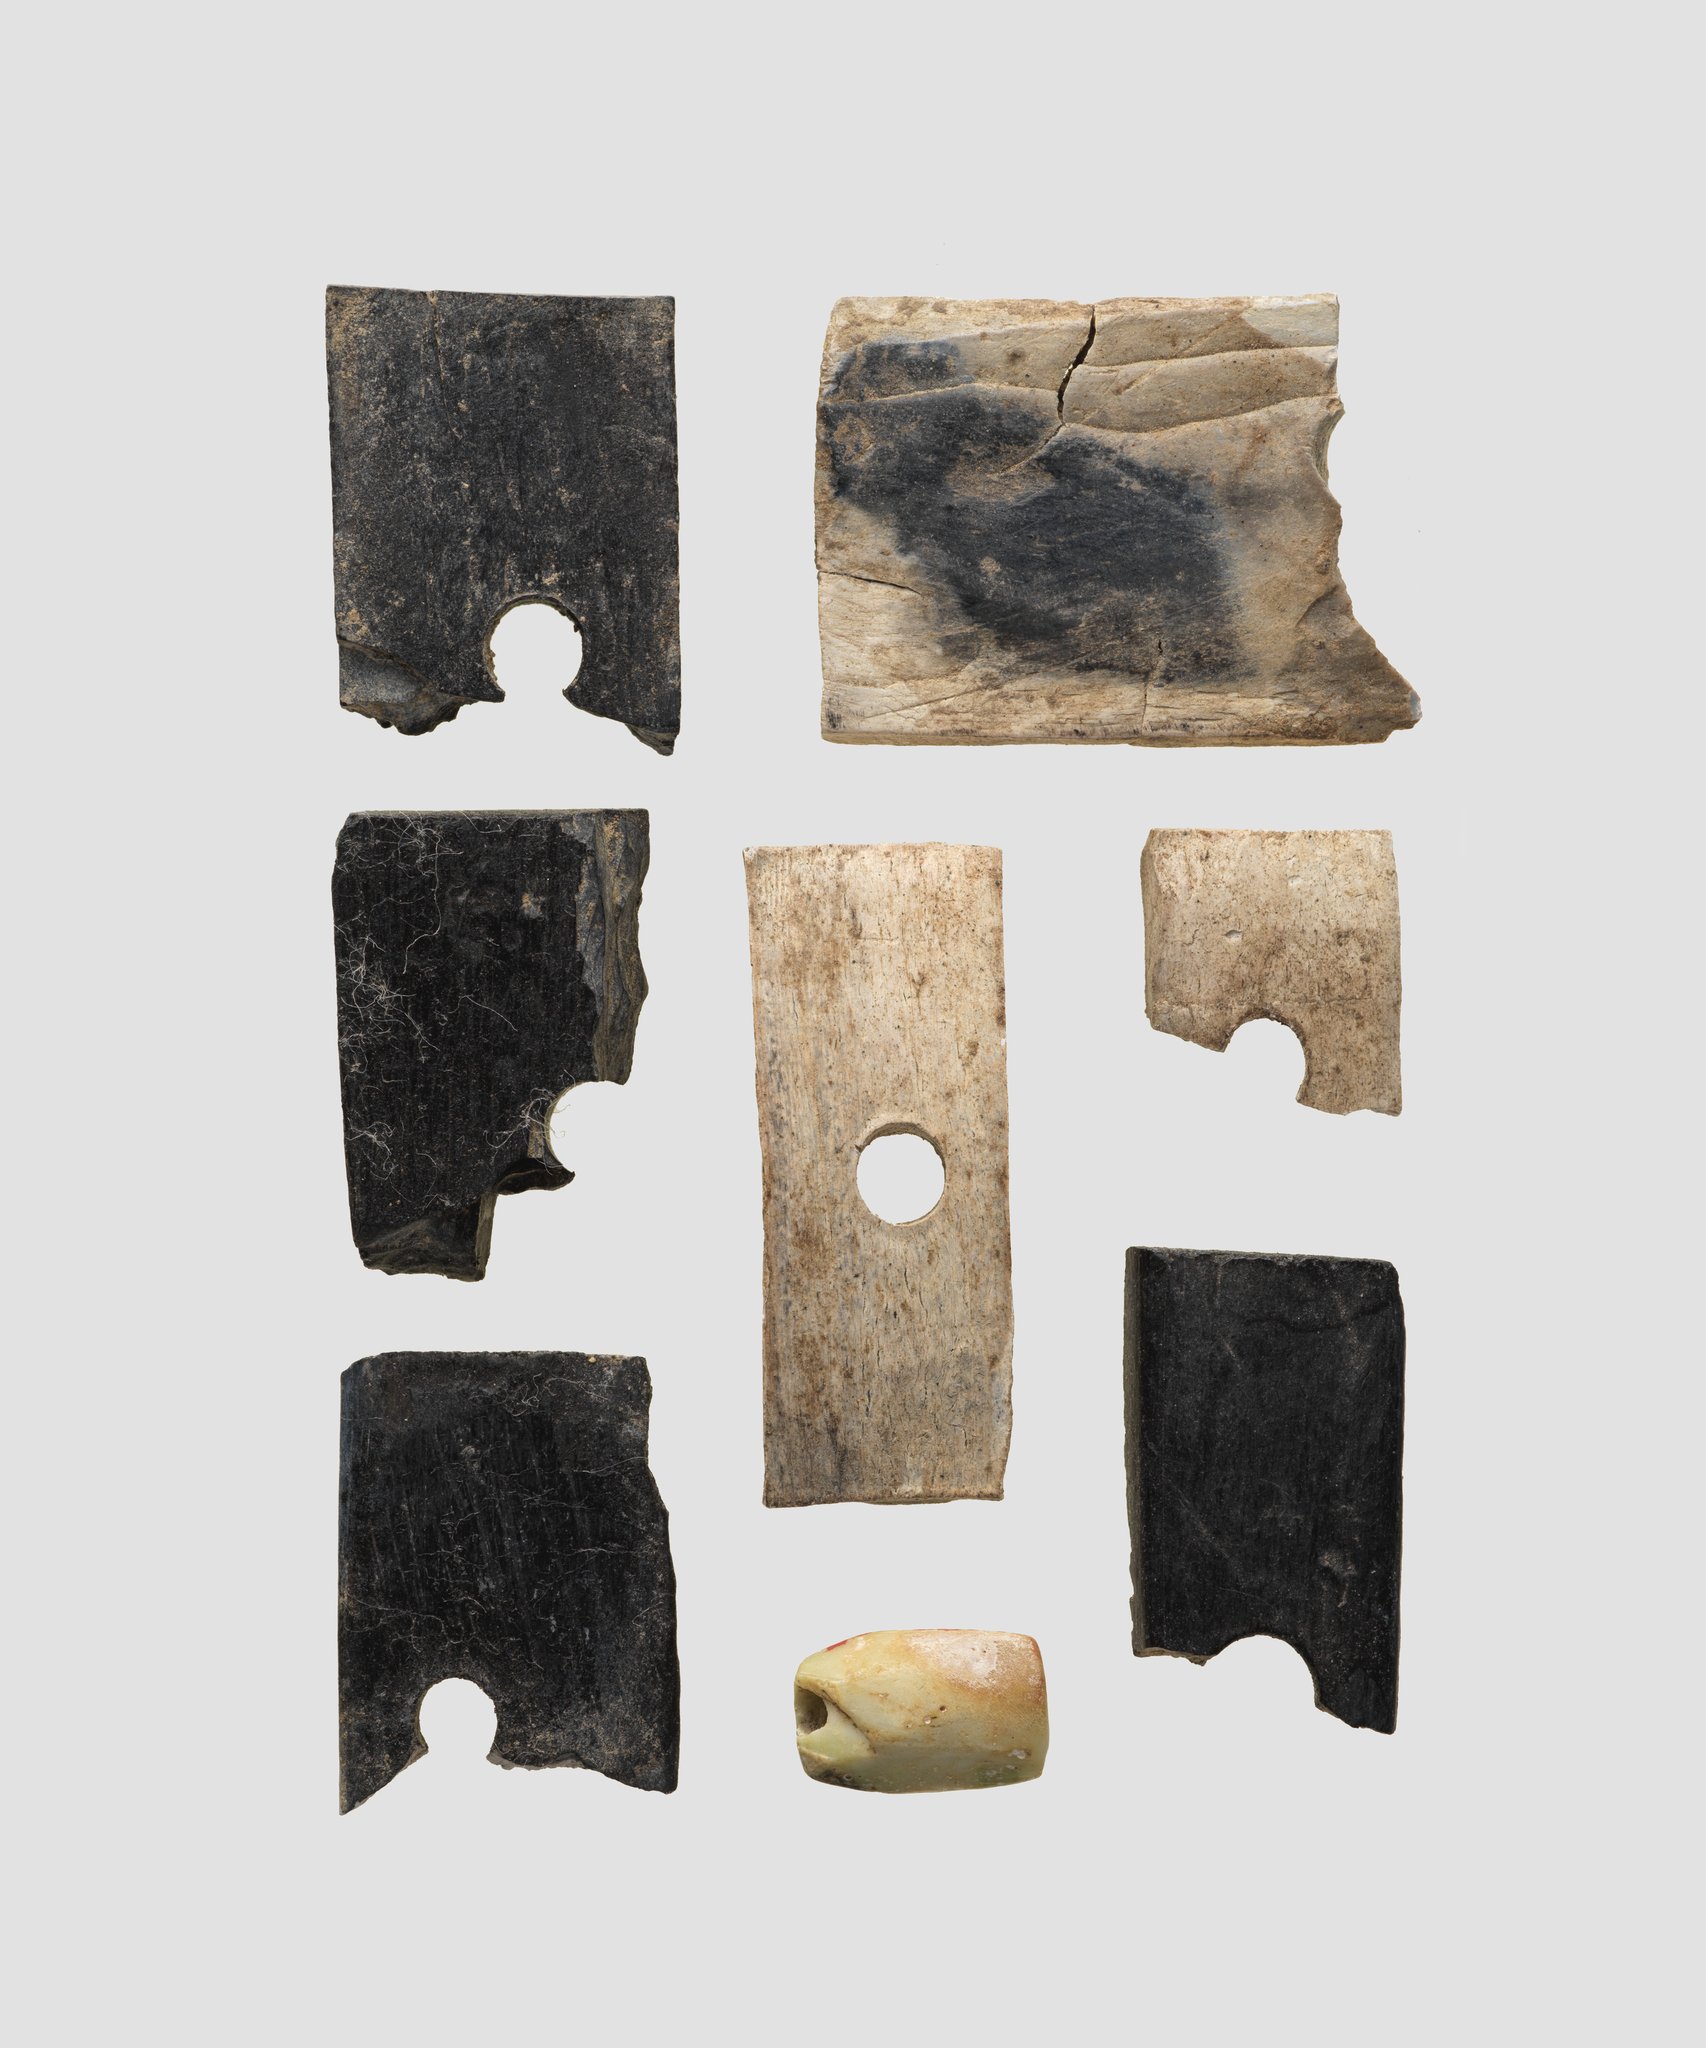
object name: inlay and bead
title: Pieces of inlay and bead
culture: iranian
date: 900-801 BCE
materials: bone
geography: iran